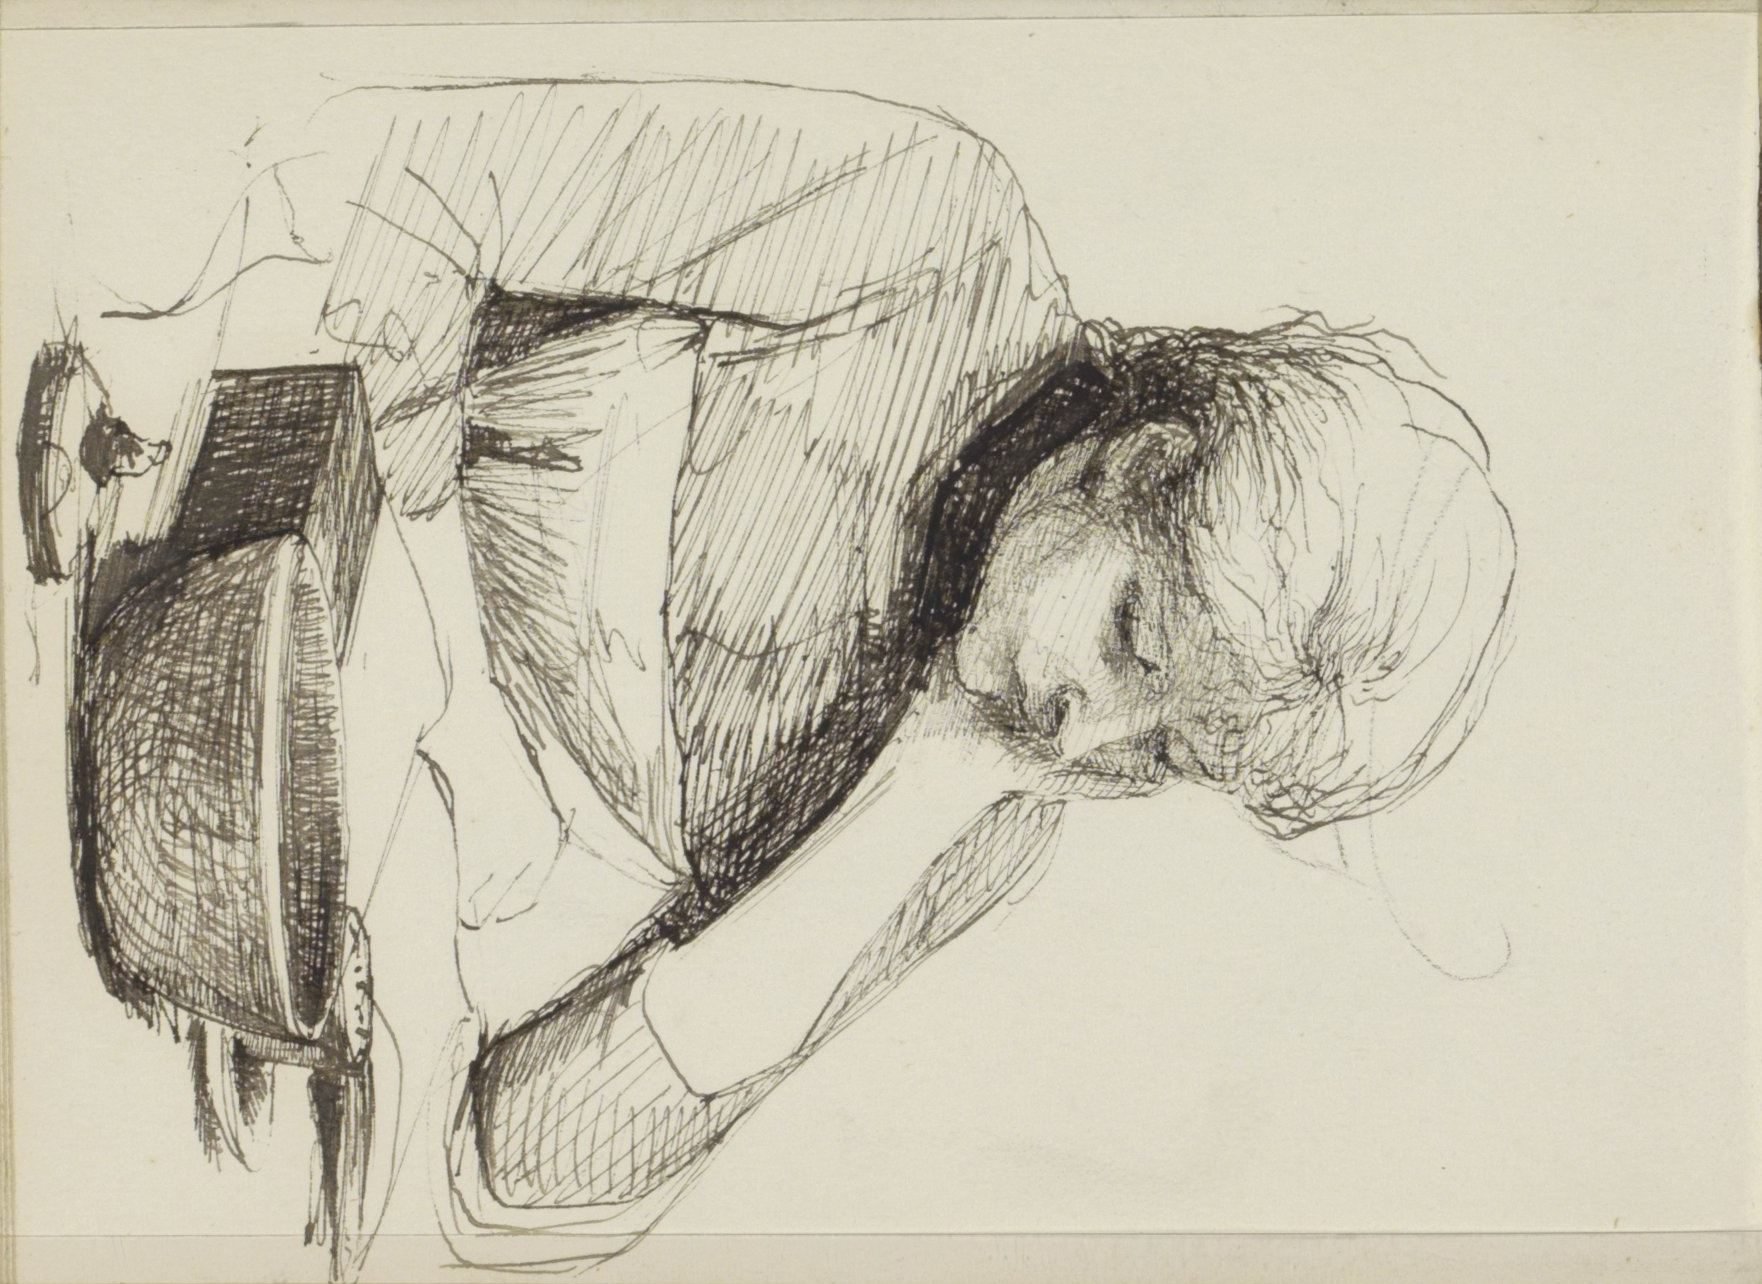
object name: sketchbook leaf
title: Lezende vrouw aan een tafel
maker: a.a.l. de grammont-hubrecht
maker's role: draughtsman, painter, print maker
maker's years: 1855-1913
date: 1865-1913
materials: ink, paper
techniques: pen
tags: adult woman, reading, table, bowl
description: Blad 27 verso uit een schetsboek met 38 bladen.